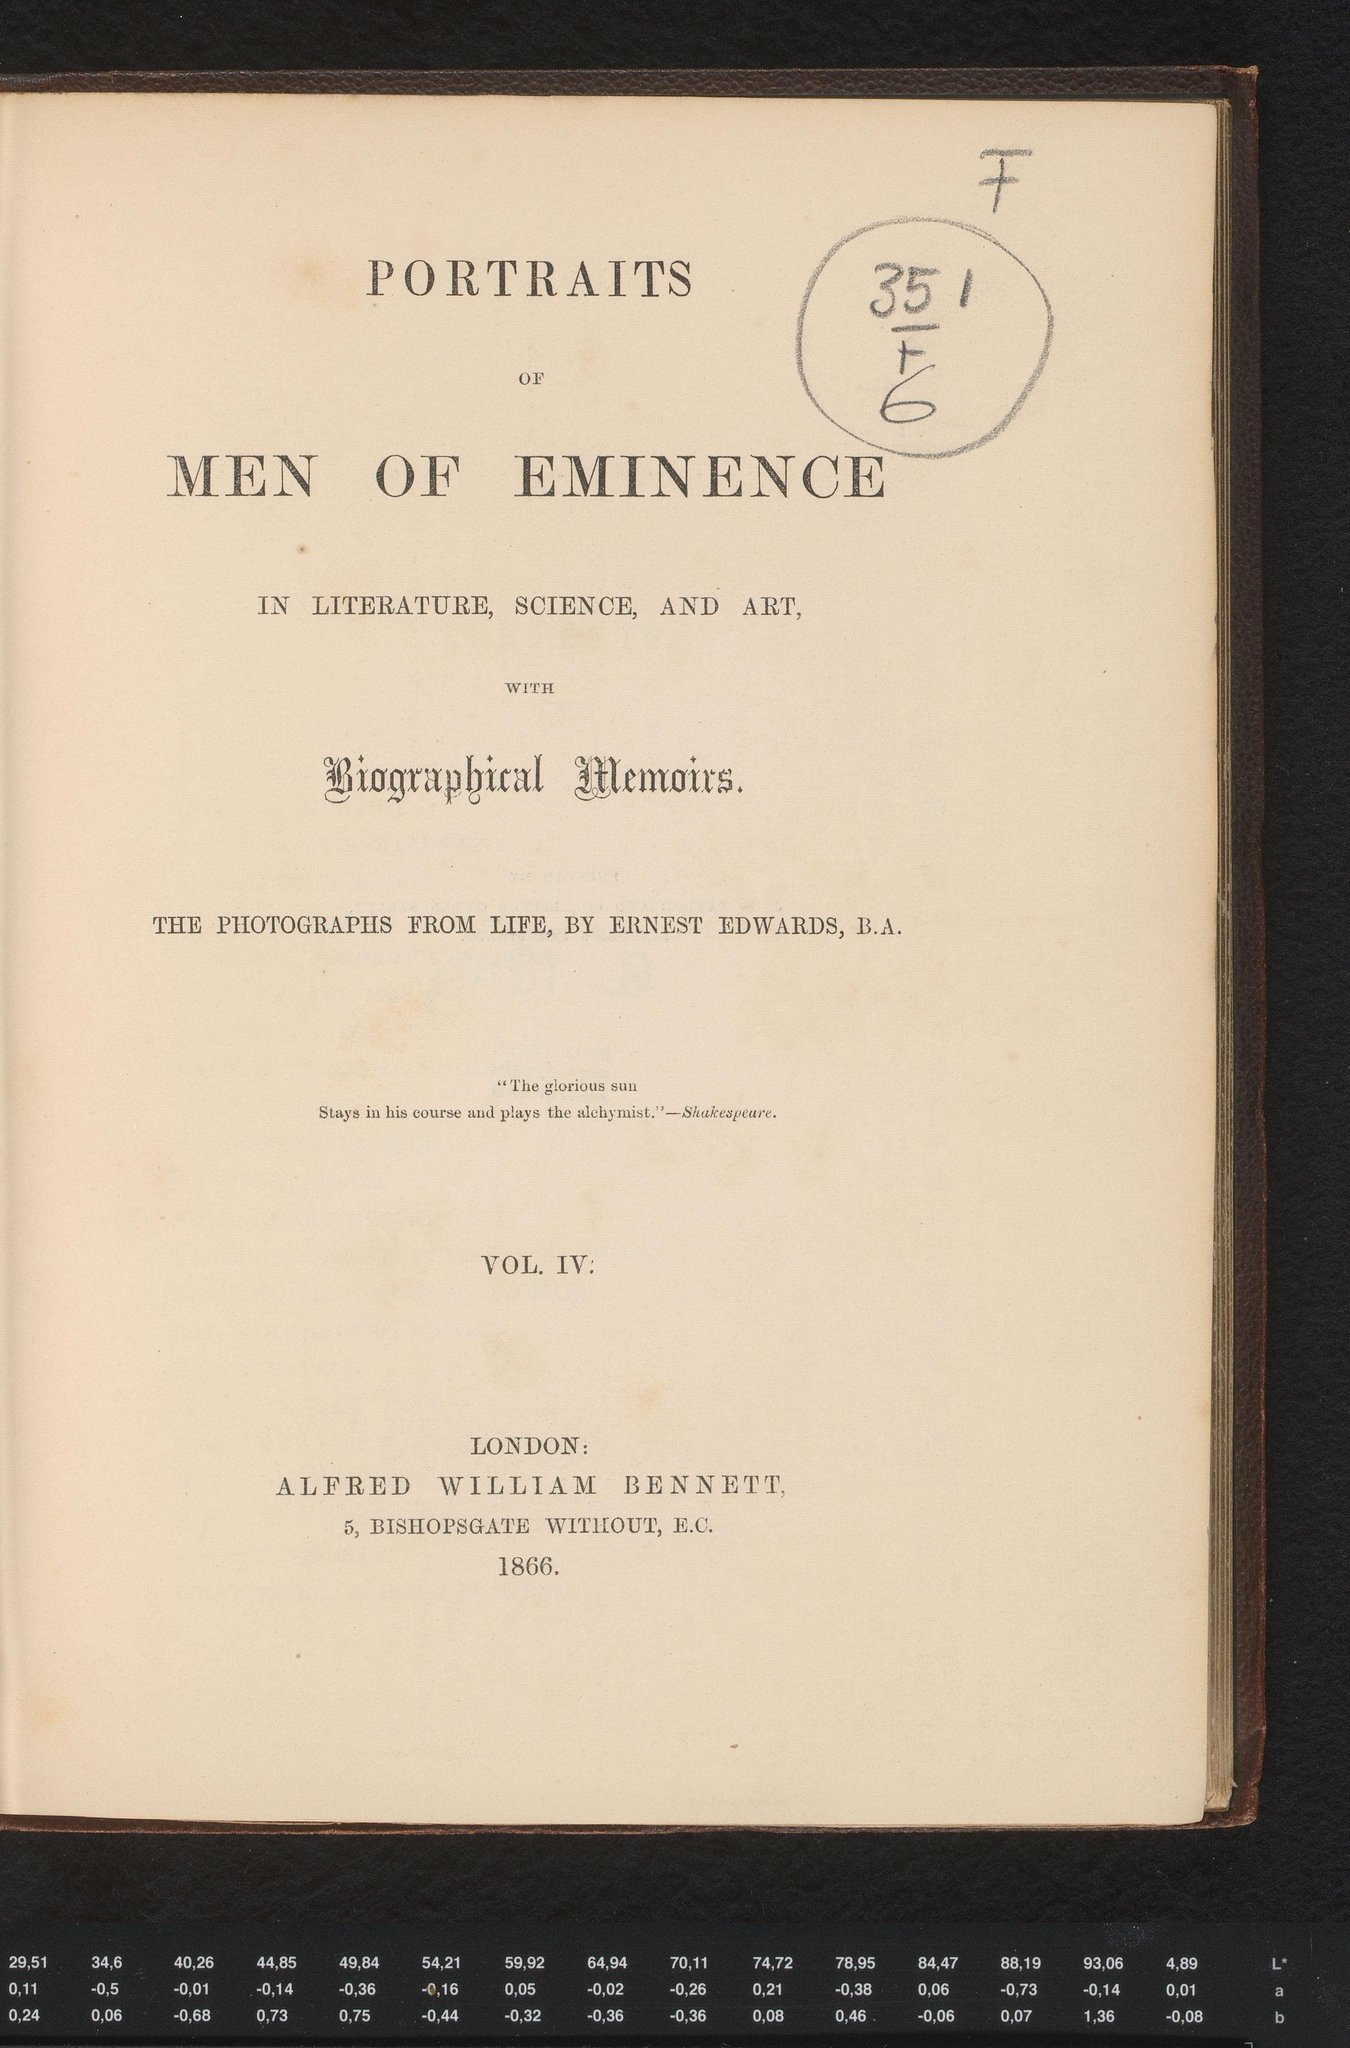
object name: book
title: Portraits of men of eminence in literature, science, and art, with biographical memoirs, dl.4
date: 1866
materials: cardboard, paper, linen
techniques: albumen print, letterpress printing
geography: london